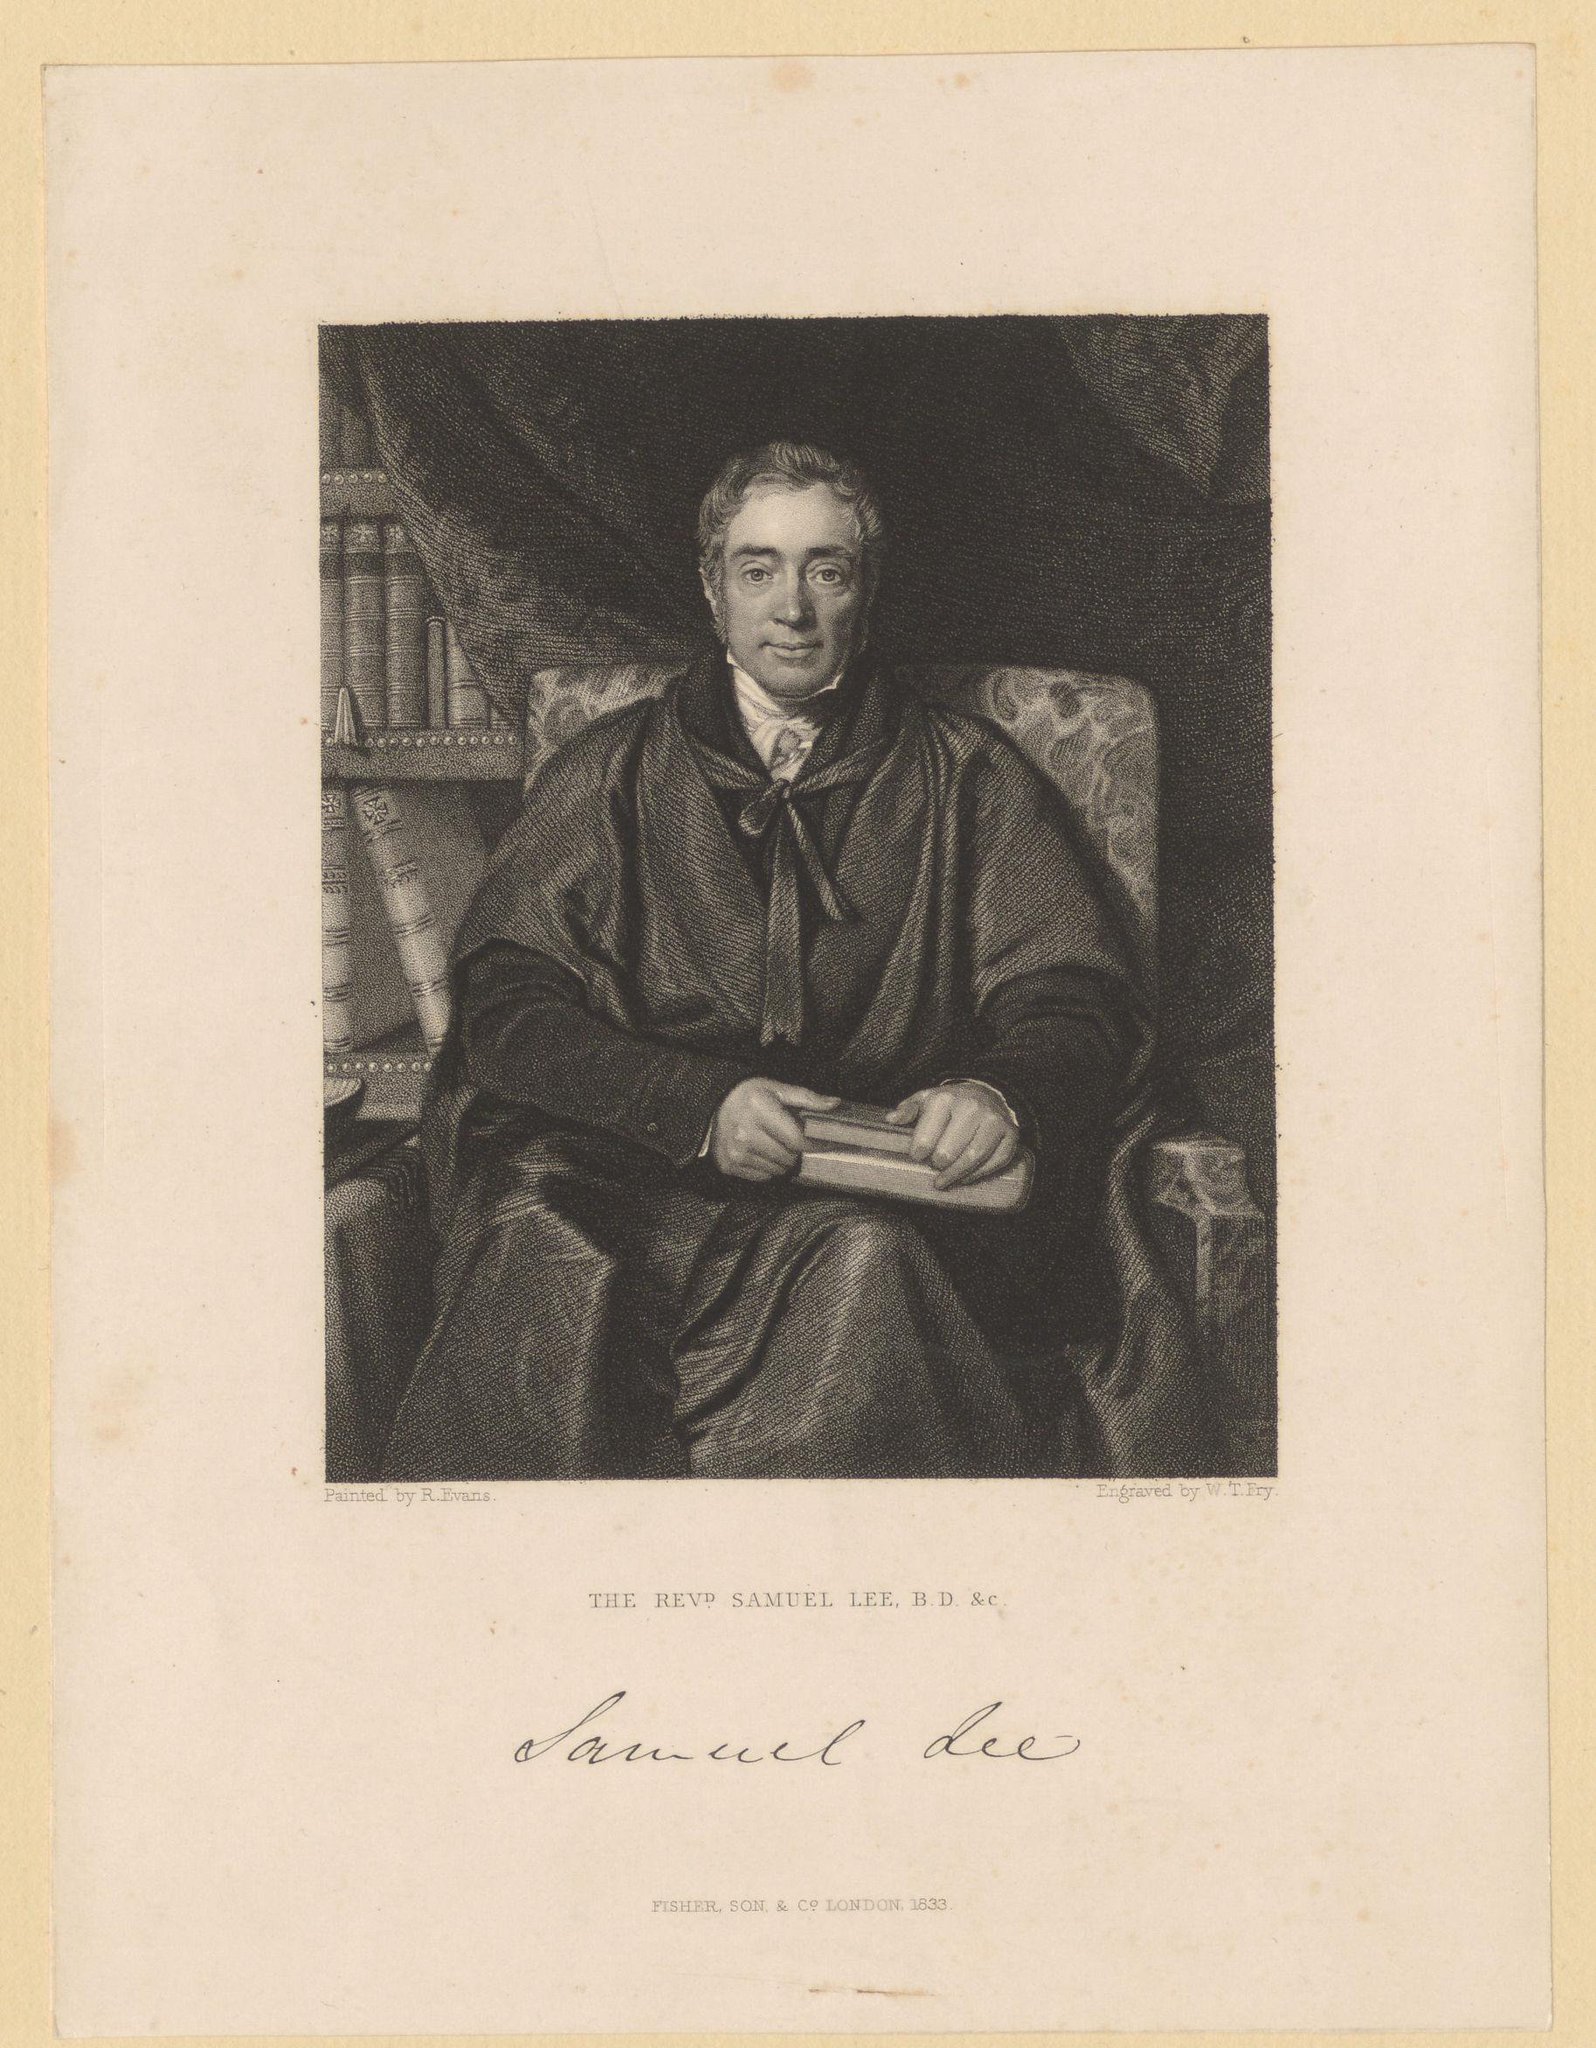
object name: print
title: Portret van Samuel Lee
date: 1833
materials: paper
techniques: etching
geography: london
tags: historical persons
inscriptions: collector's mark: Lugt 2228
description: Prent gebruikt in: Jerdan, William. National Portrait Gallery of Illustrious and Eminent Personages of the Nineteenth Century (...). Londen: Fisher, Son & Co., 1833.